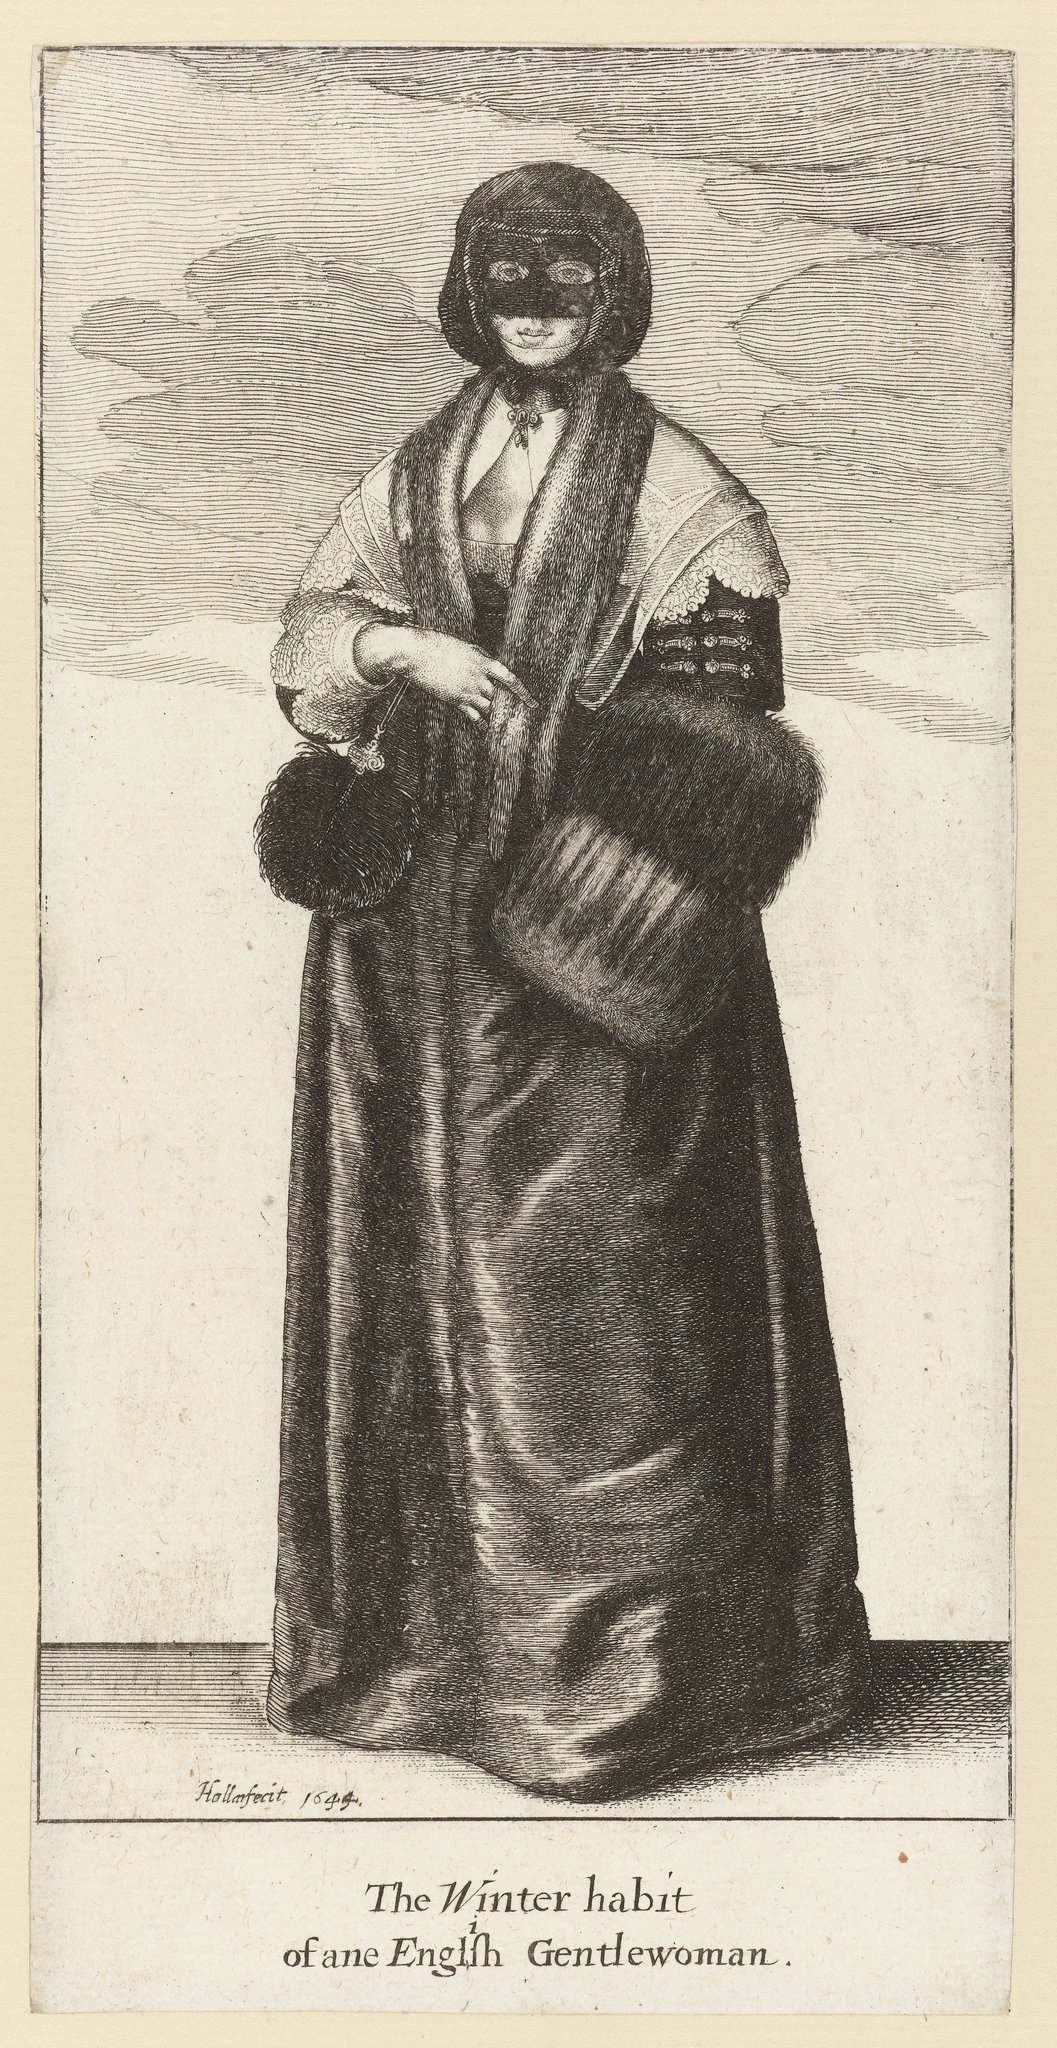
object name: print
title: The winter habit of an English Gentlewoman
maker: wenceslaus hollar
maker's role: draughtsman, print maker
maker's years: 1607-1677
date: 1644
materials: paper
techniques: etching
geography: london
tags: neck-gear ~ clothing (neckerchief) (+ women's clothes), black velvet or satin mask, 'loup', 'cachenez' (+ women's clothes), winter, 'hyems'; 'inverno' (ripa), neck-gear: collar (+ women's clothes), clothes, costume (+ women's clothes), skirt (+ women's clothes), dress, gown (+ women's clothes), muff (+ fur used for clothes), clothing for the upper part of the body (with name) (+ women's clothes), muff (+ women's clothes), england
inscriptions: collector's mark: Lugt 2760, collector's mark: Lugt 2228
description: Engelse dame gekleed in een winterskostuum met stola en mof van bont. Haar gezicht is gedeeltelijk bedekt met een maskertje van fluweel, op het hoofd een zwarte hoofddoek. Aan haar rechterpols hangt een waaier.